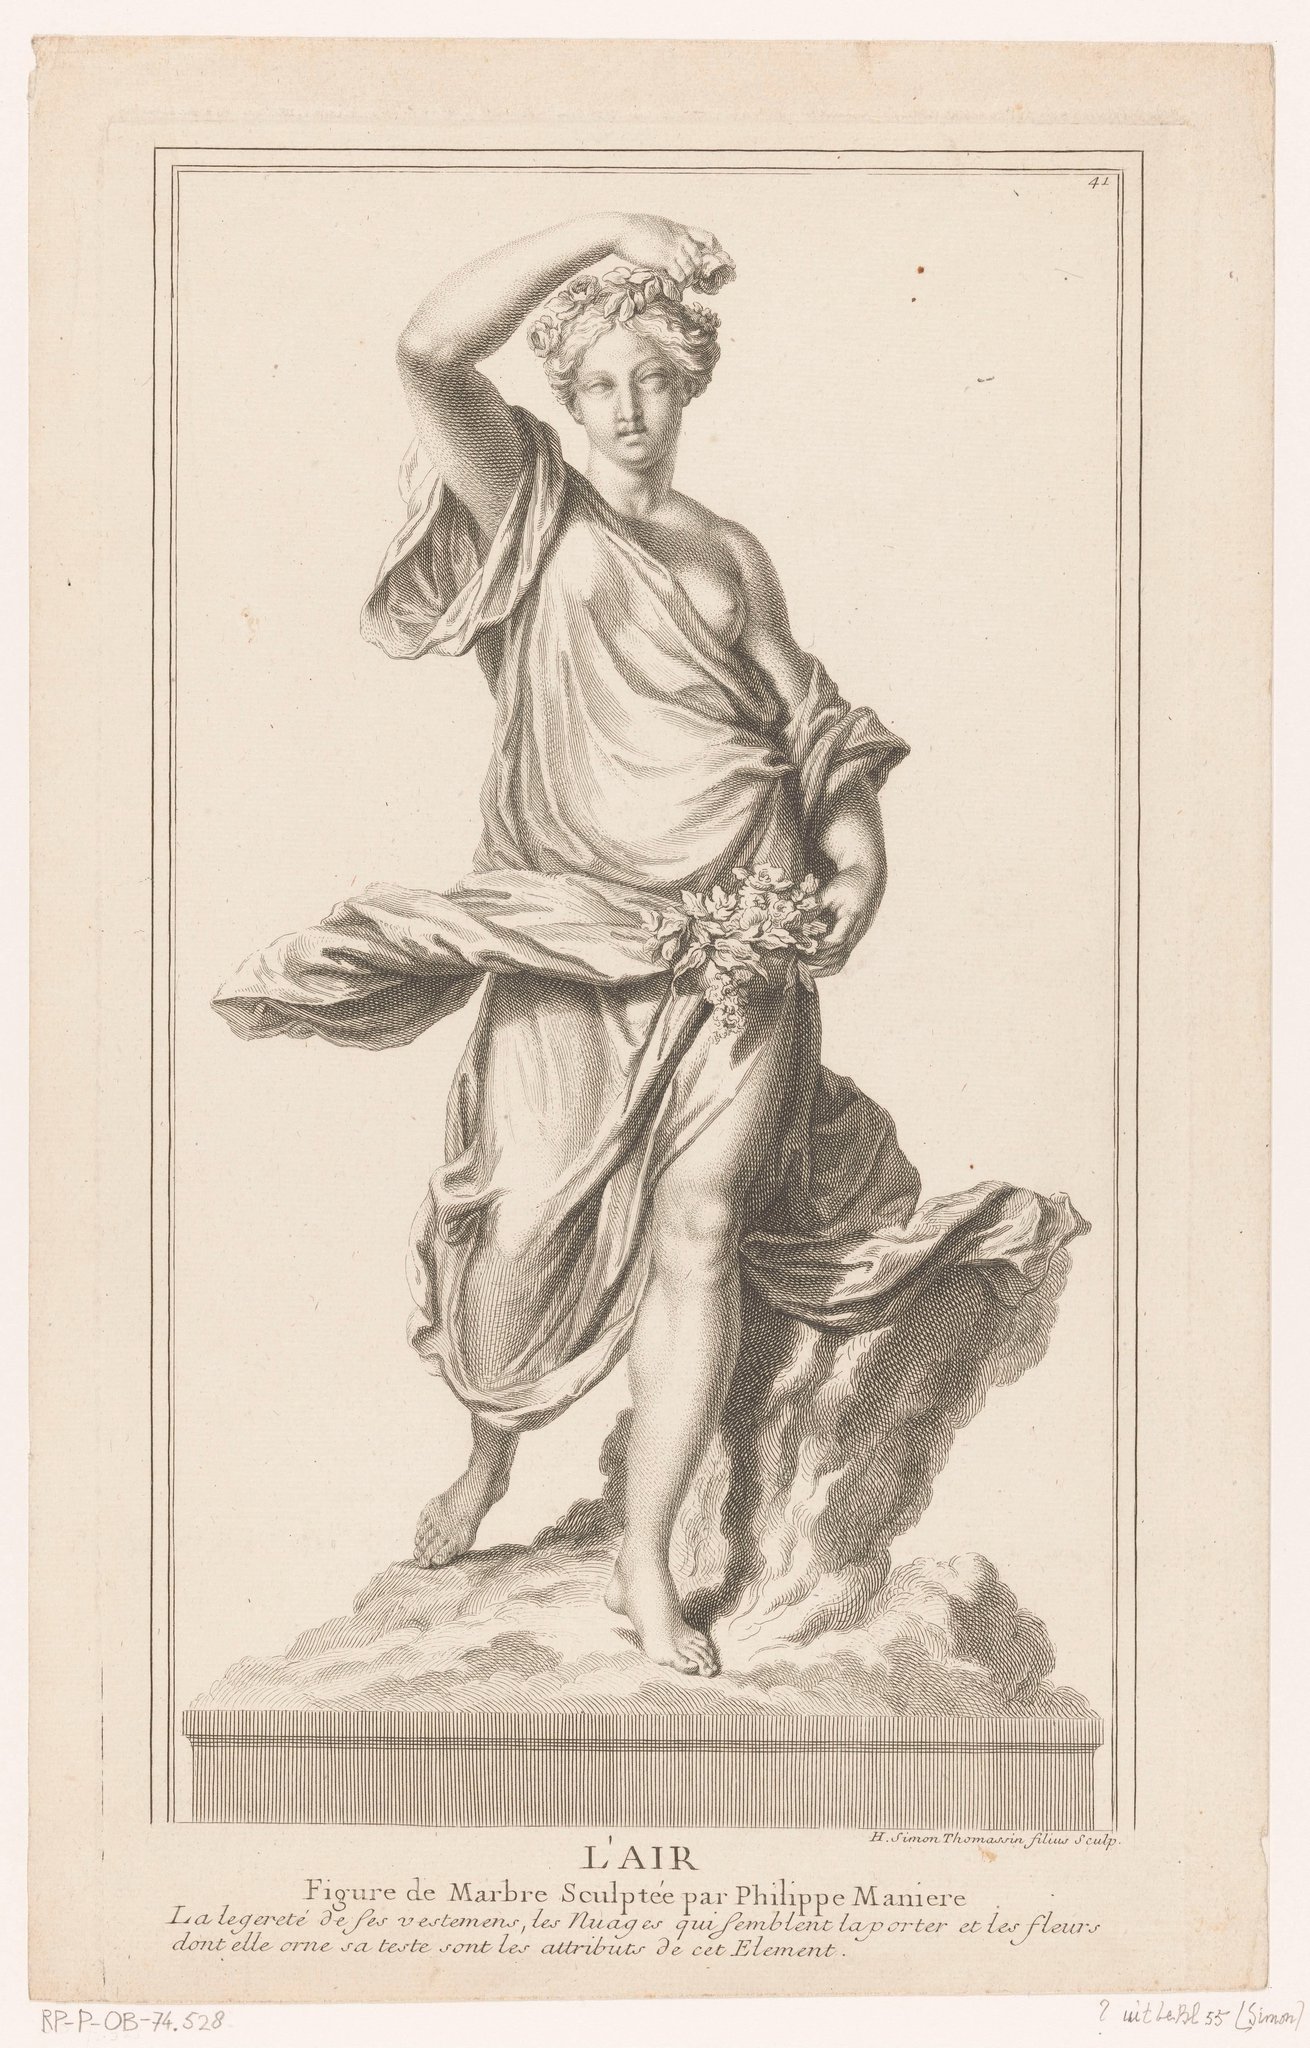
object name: print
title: Recueil de cinquante des plus belles figures antiques et moderns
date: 1703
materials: paper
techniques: engraving, etching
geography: versailles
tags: (showing oneself) undressed, quasi-nude, clouds, sculpture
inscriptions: collector's mark: Lugt 2228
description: Maakt deel uit van een serie van vijftig prenten getiteld: "Recueil de cinquante des plus belles figures antiques et moderns", uitgegeven door Simon Thomassin in 1703 en opgedragen aan koning Lodewijk XIV van Frankrijk.